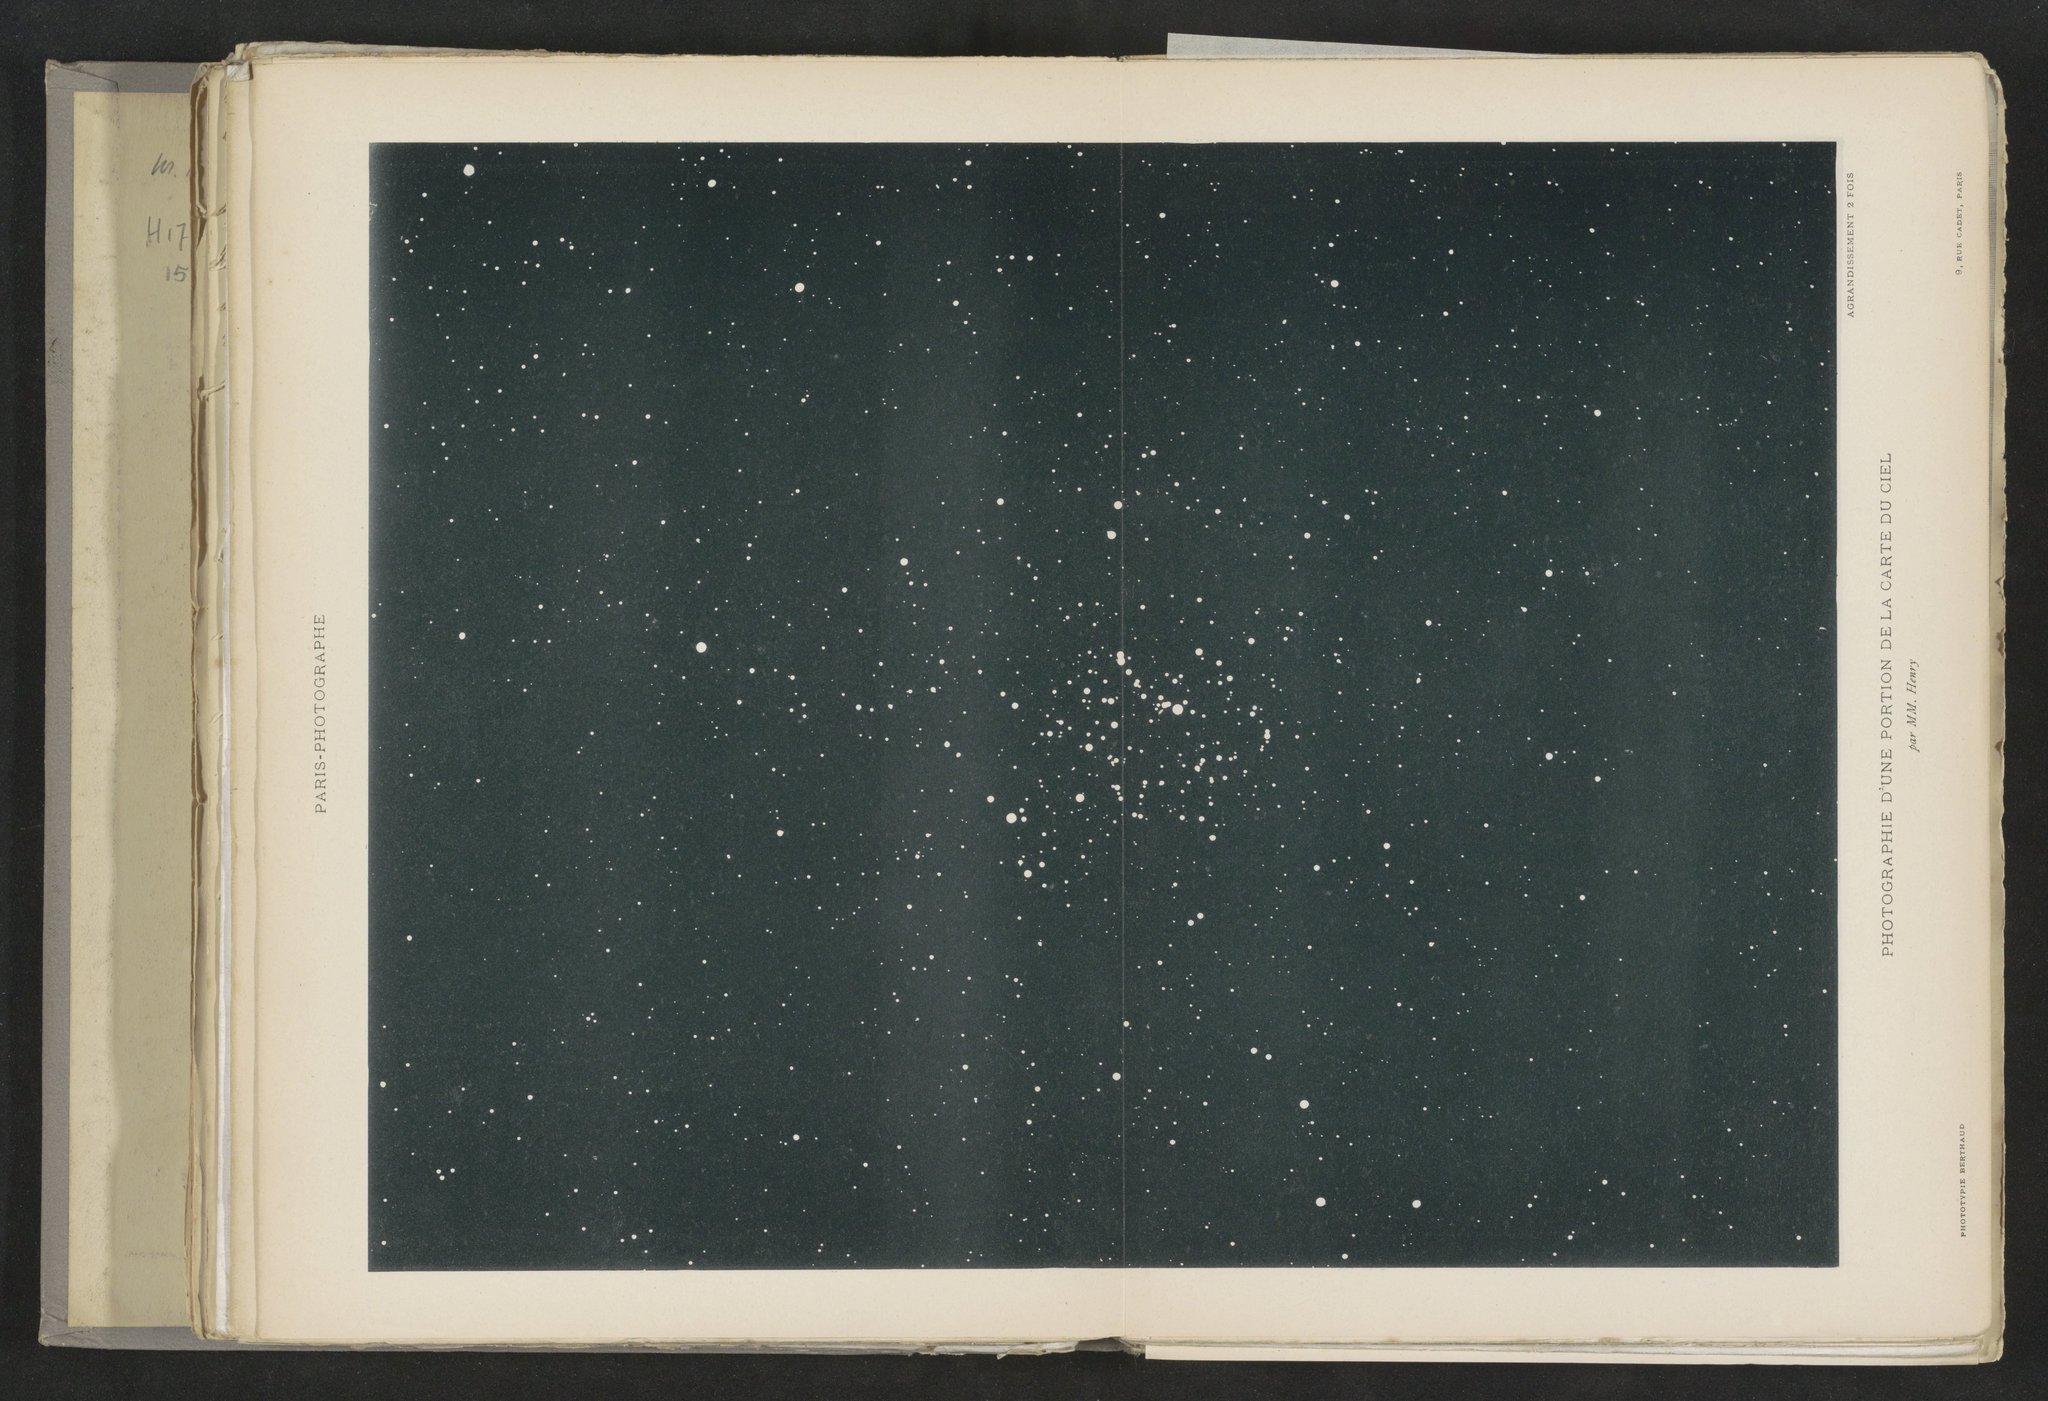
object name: page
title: Photographie d'une portion de la carte du ciel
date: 1881-1891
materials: paper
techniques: photograph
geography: france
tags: stars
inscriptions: inscription: ‘agrandissement 2 fois’